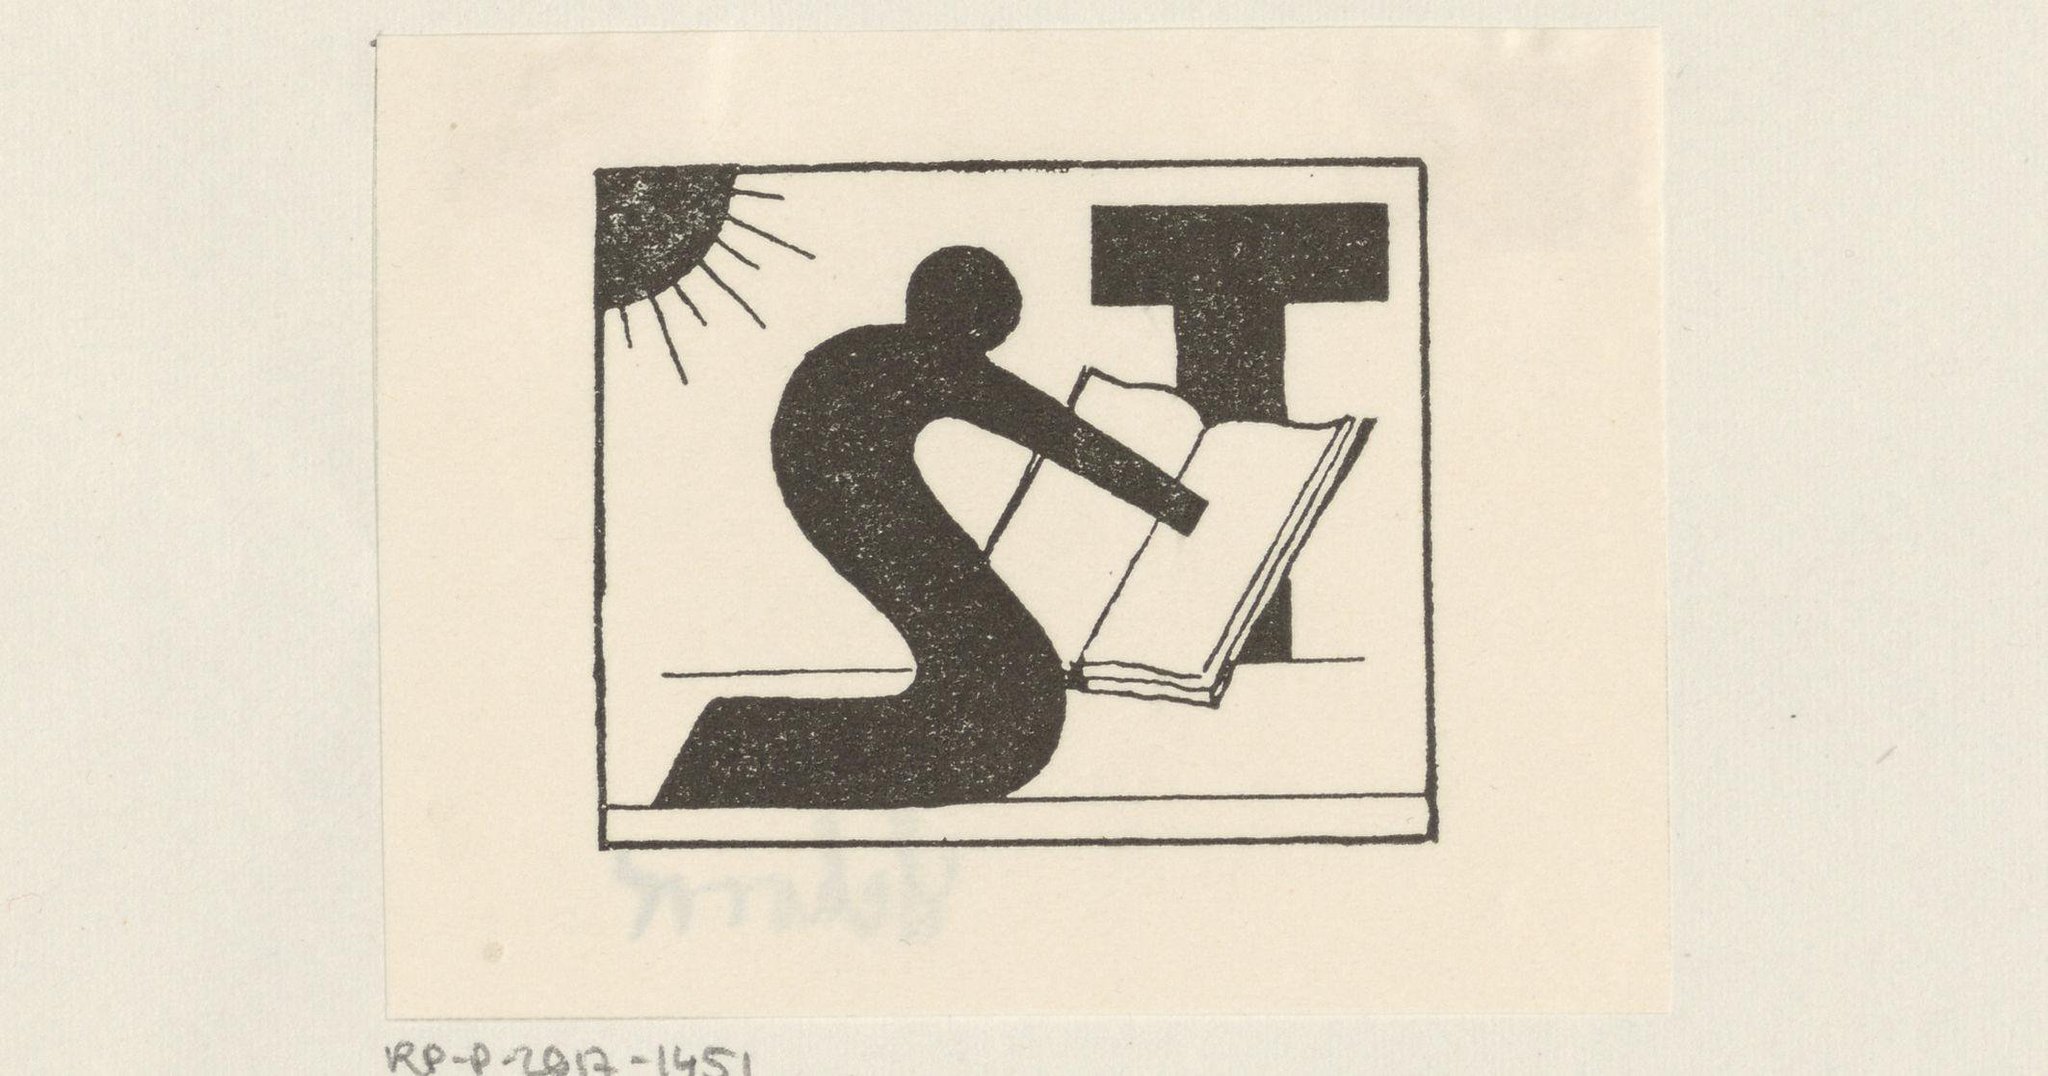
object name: bookplate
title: Ex libris van S.T.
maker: Anonymous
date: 1900-1999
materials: paper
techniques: printing block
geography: hungary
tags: print maker, tibor schorr, sitting figure, reading, sun as celestial body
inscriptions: inscription: ‘Schorr’